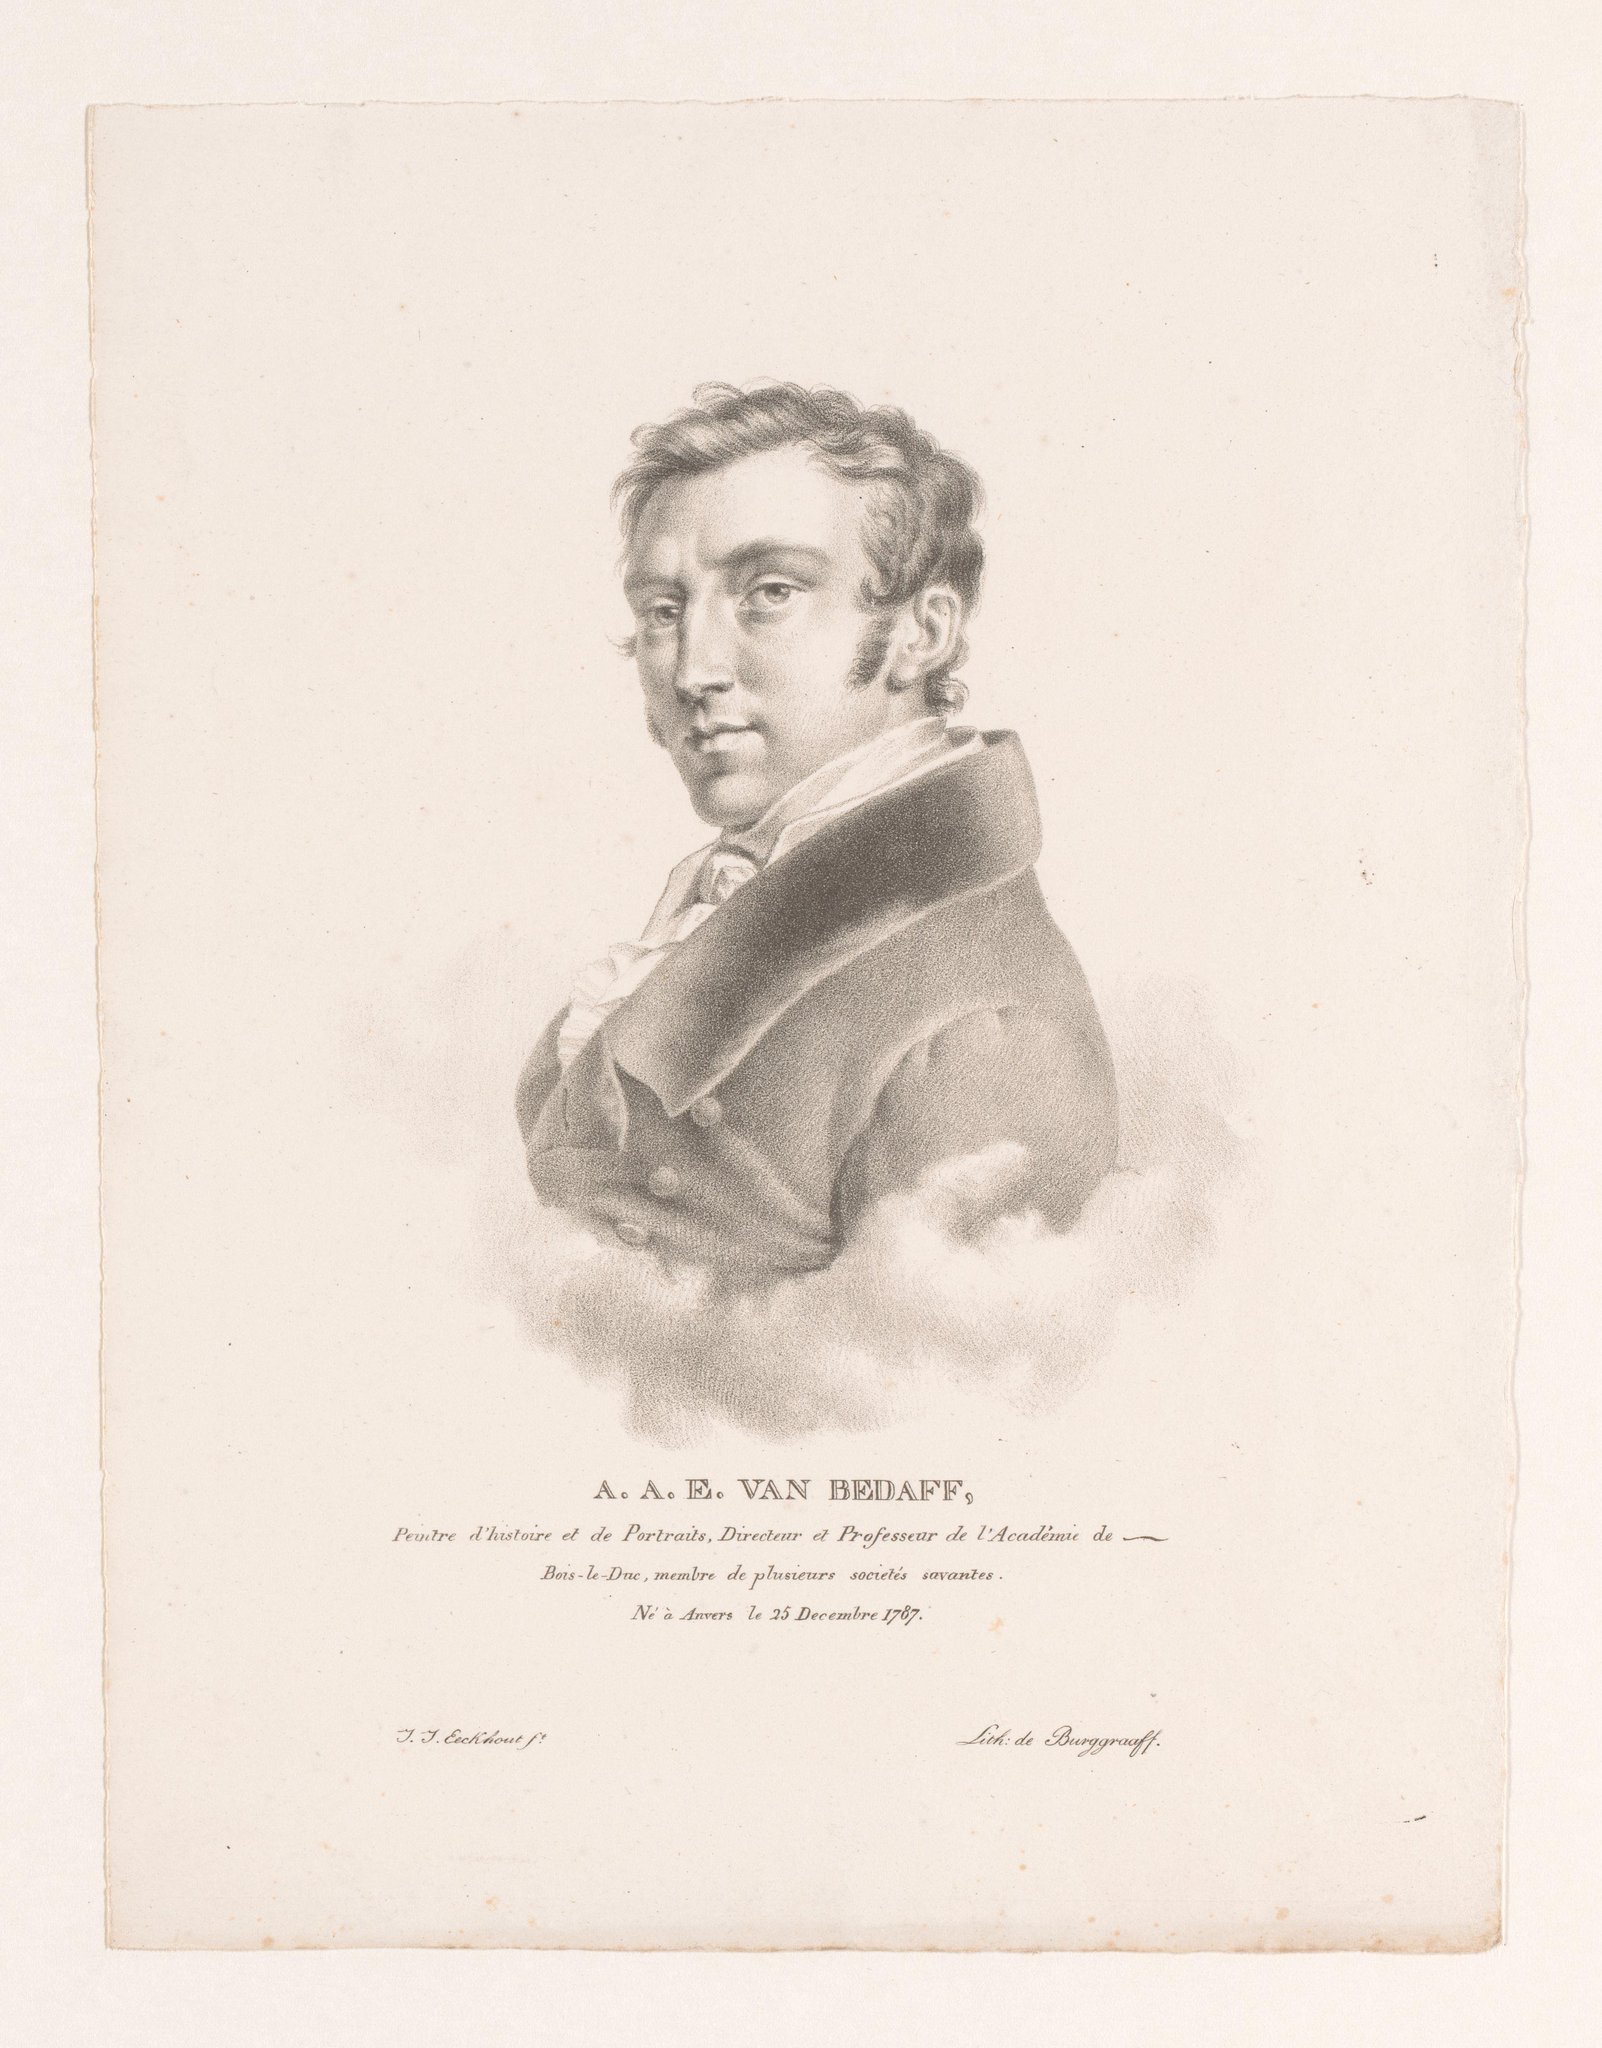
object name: print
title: Portraits des artistes modernes nés dans le Royaume des Pays-Bas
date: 1822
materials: paper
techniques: lithograph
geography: brussels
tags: brussels, antonis aloisius emanuel van bedaff, historical persons, portrait, self-portrait of painter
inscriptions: collector's mark: Lugt 2228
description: Prent maakt deel uit van een serie van zestig prenten.